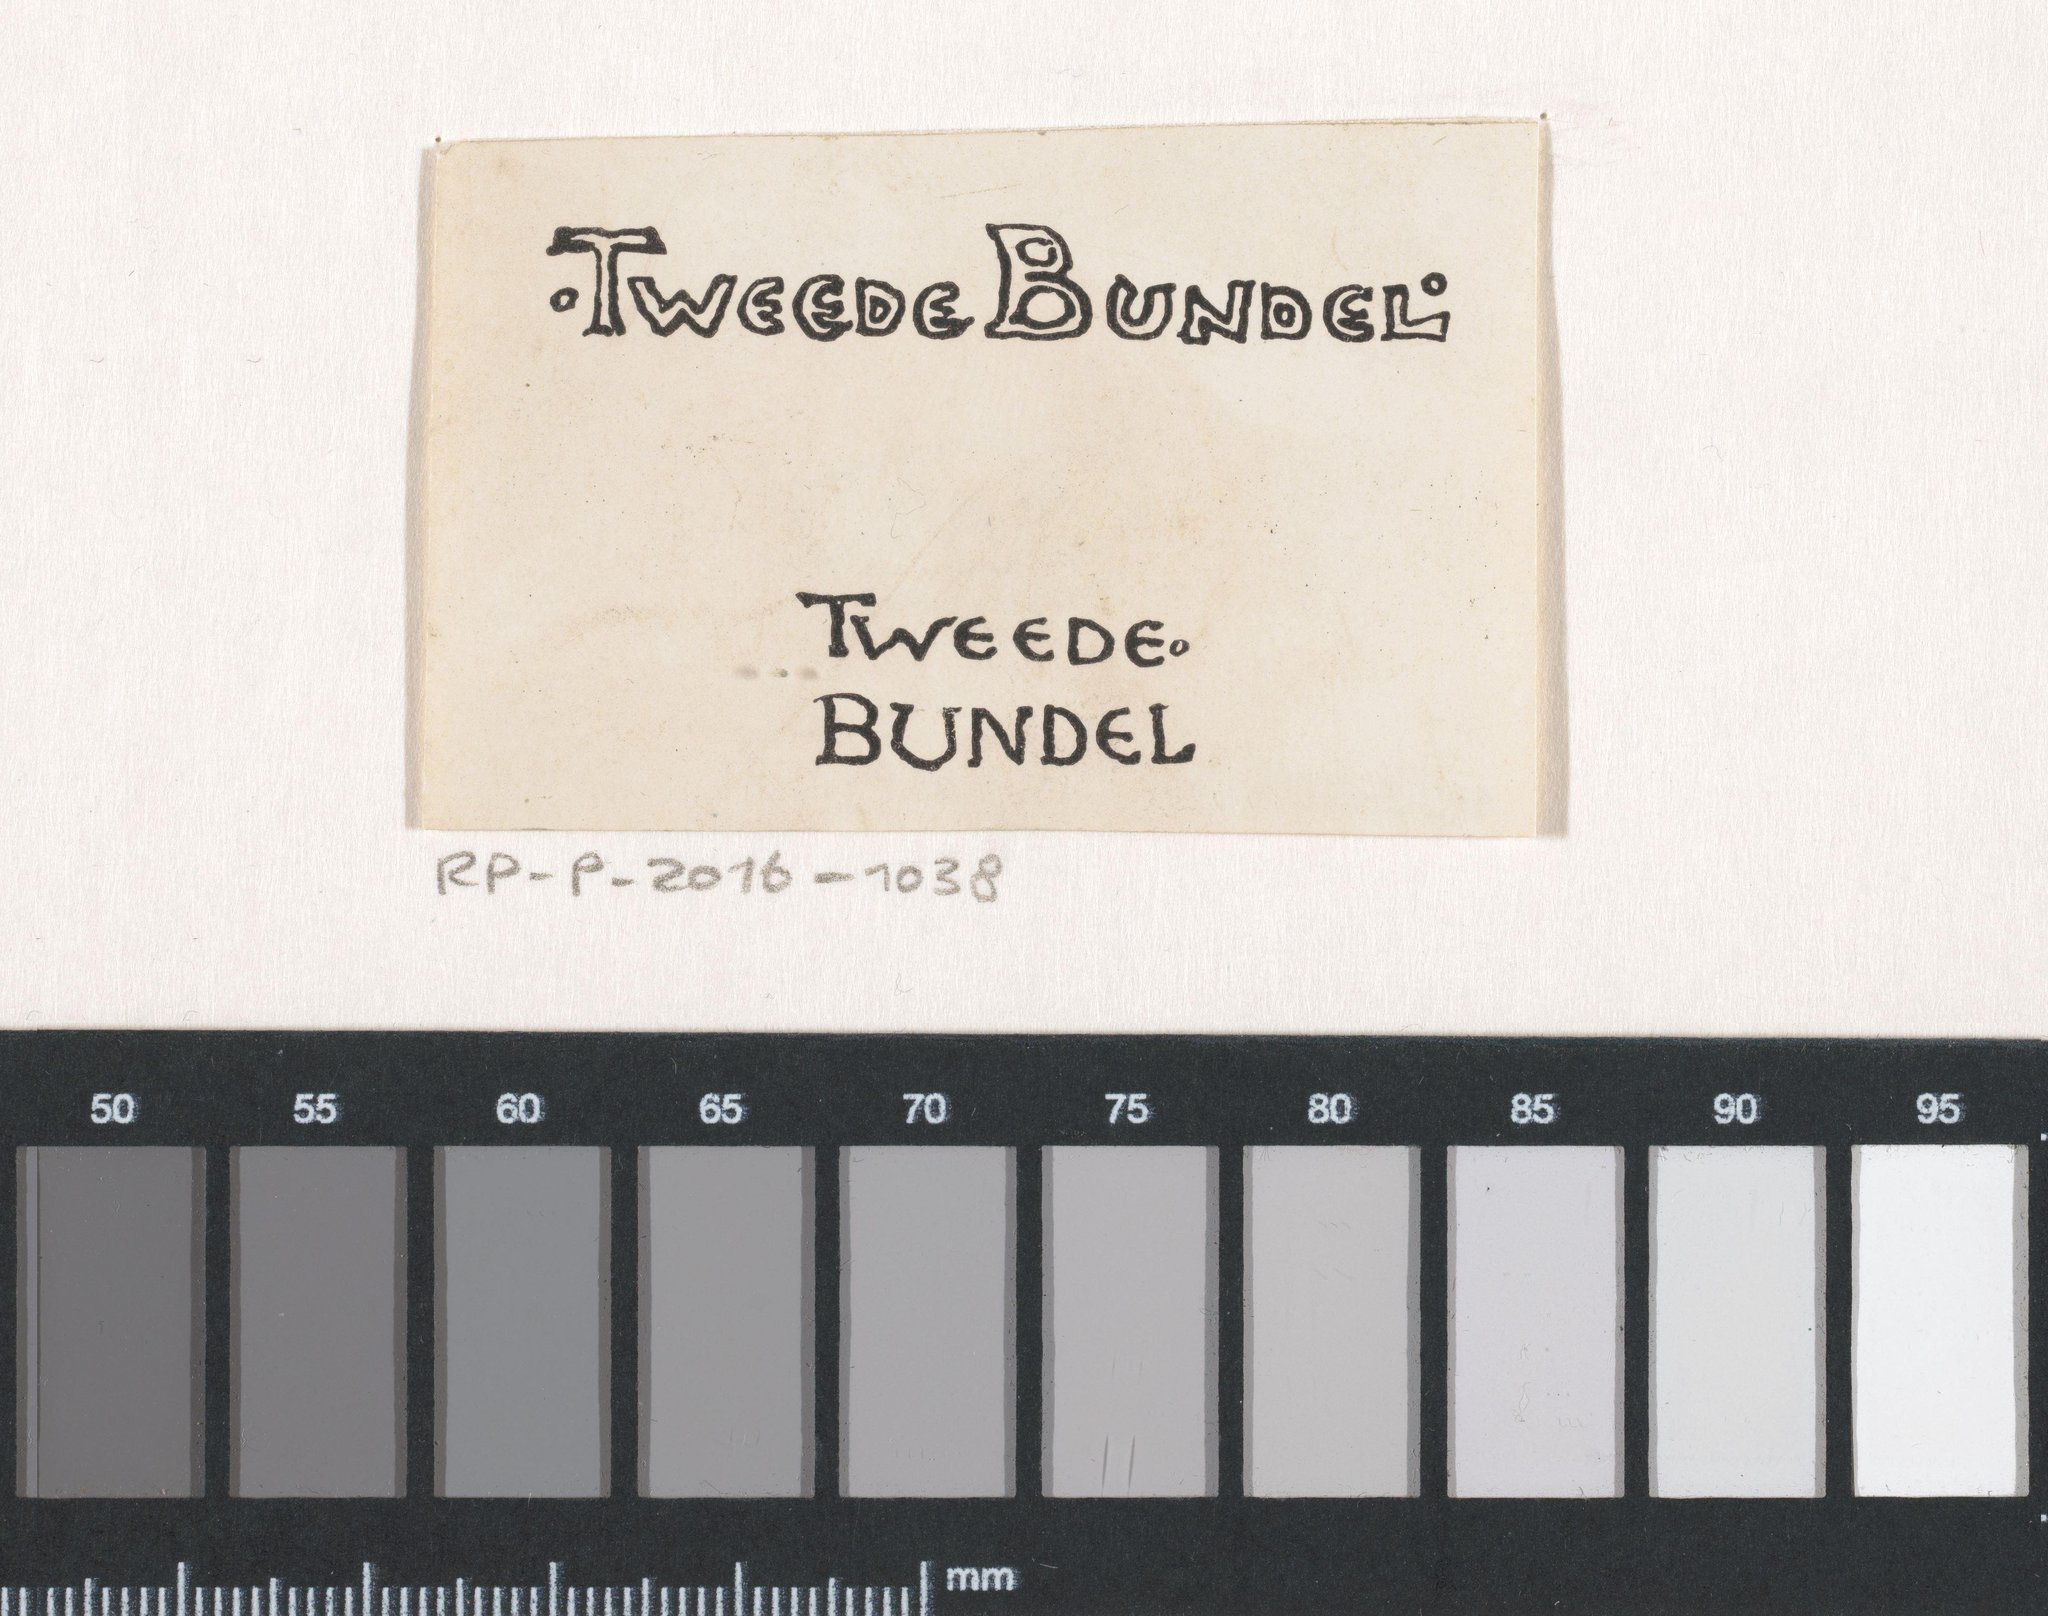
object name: photomechanical print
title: Typografisch ontwerp voor een bundel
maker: Anonymous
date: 1870-1937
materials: paper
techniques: printing block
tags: letters, alphabet, script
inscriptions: collector's mark: Lugt 2228